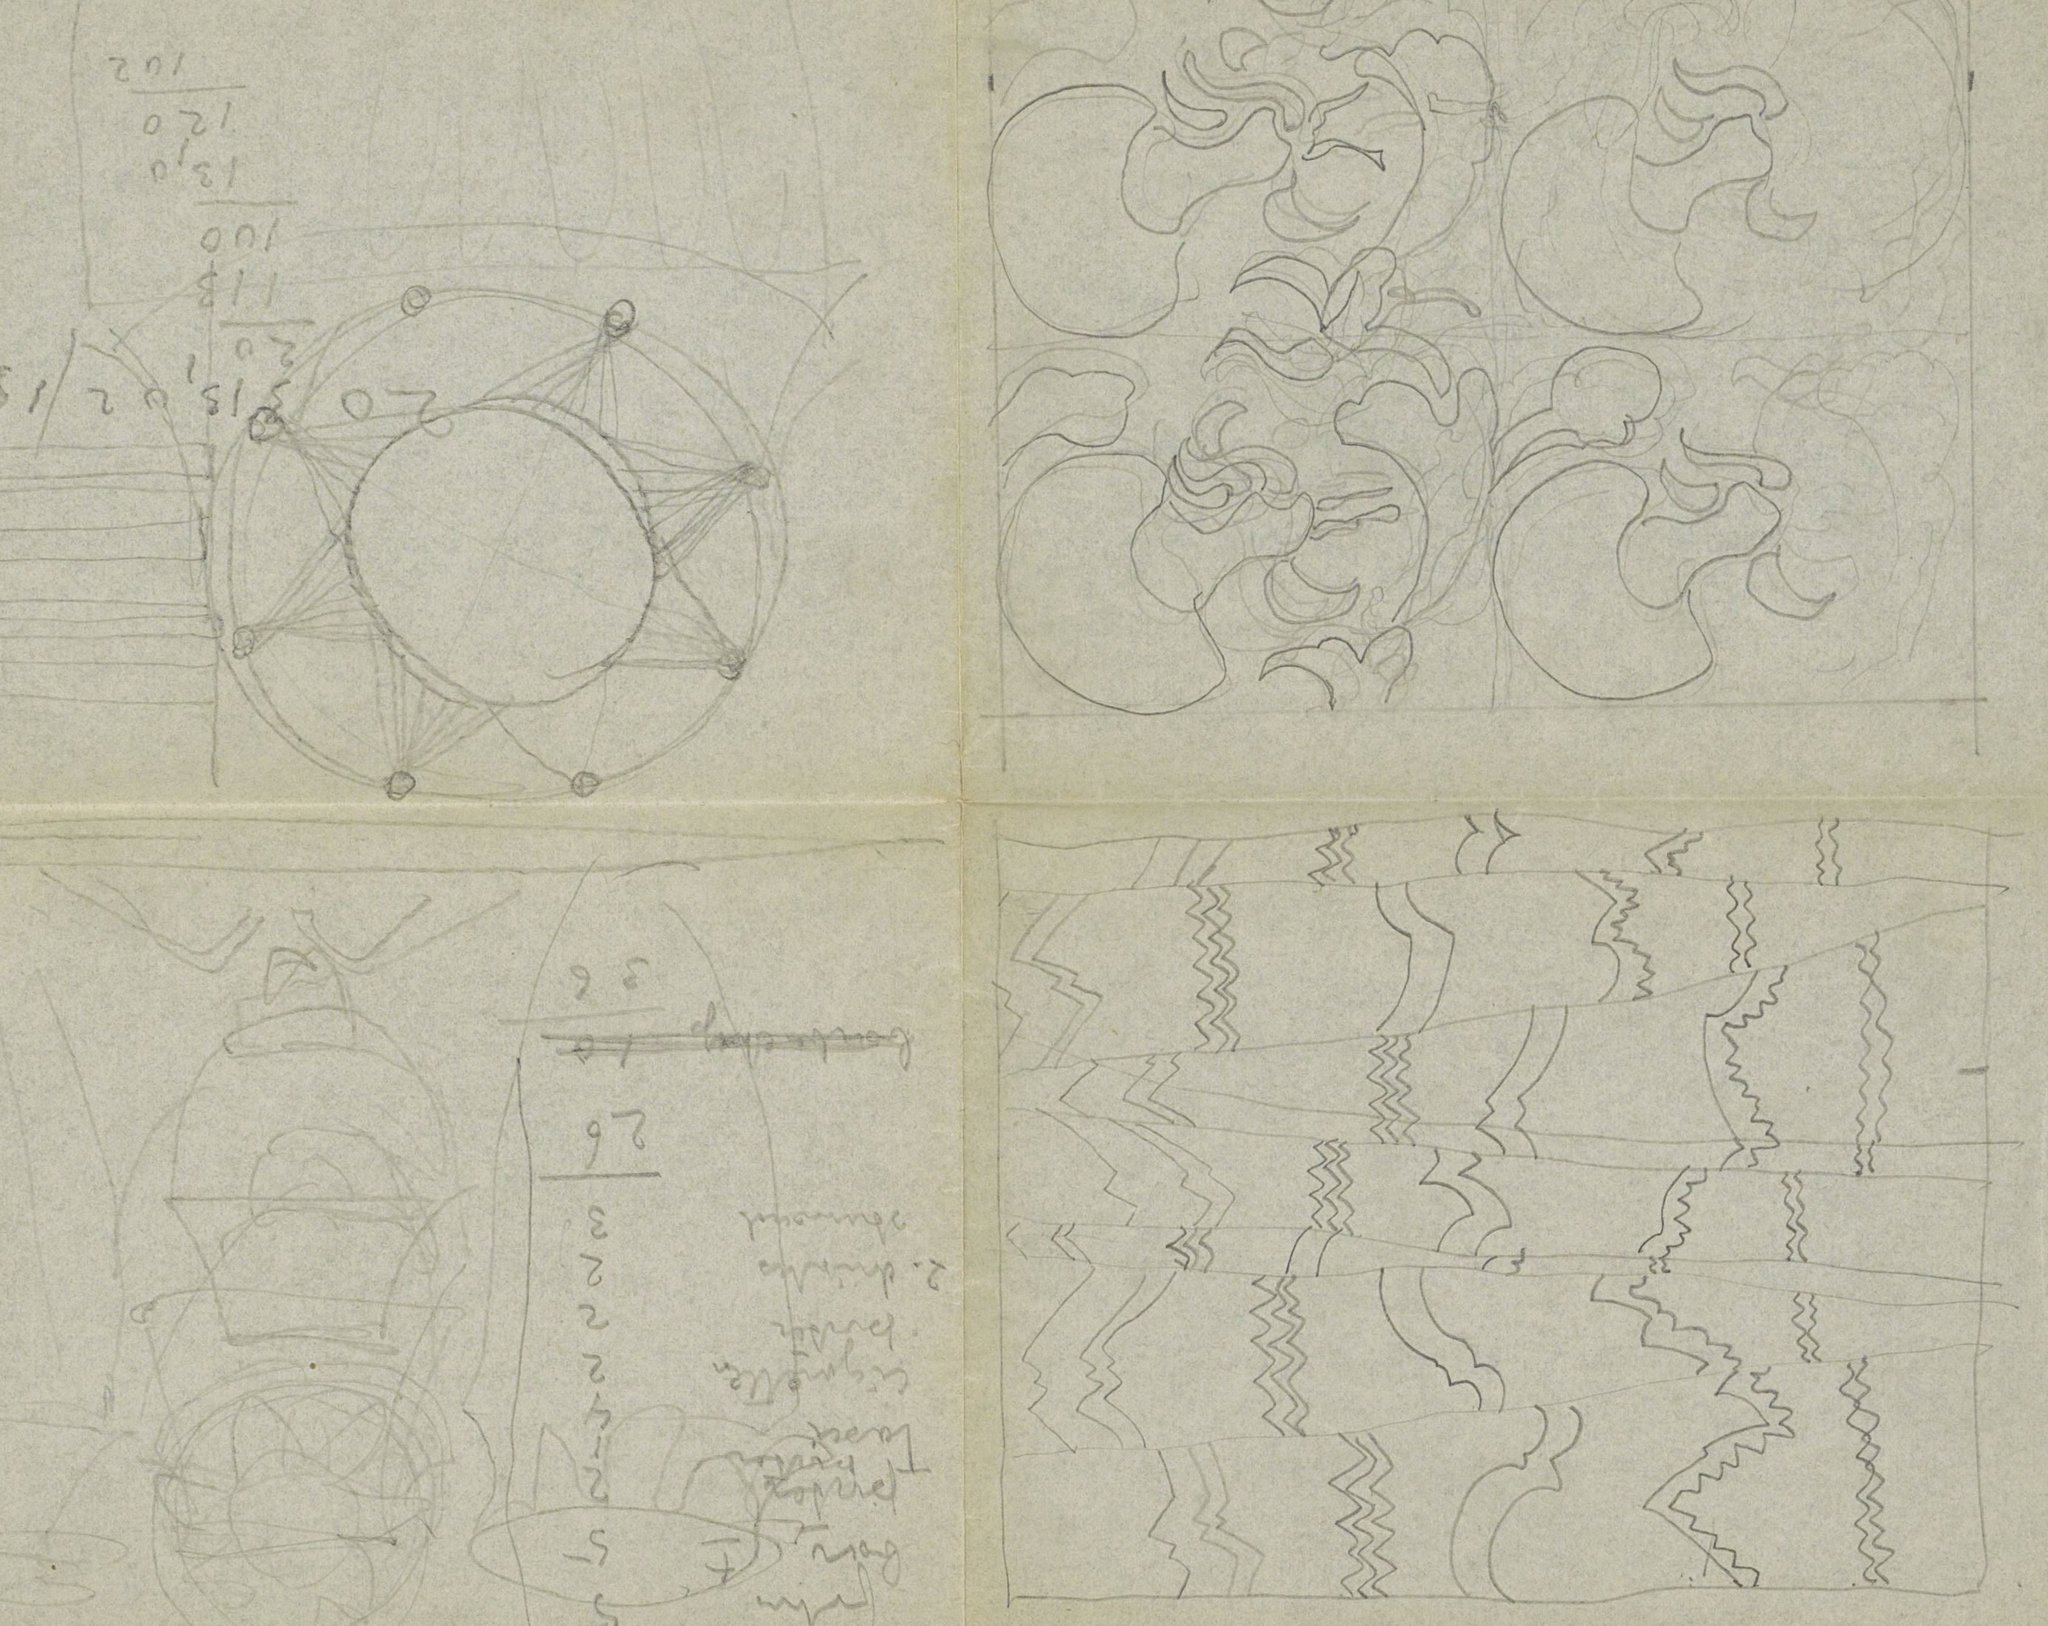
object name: sketchbook leaf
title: Decoratieve motieven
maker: reijer stolk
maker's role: draughtsman, print maker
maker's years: 1896-1945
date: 1916-1945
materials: paper, pencil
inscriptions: annotation: ‘[...]’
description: Los blad tussen het voorste schutblad en blad 1 recto uit een schetsboek met 60 bladen.